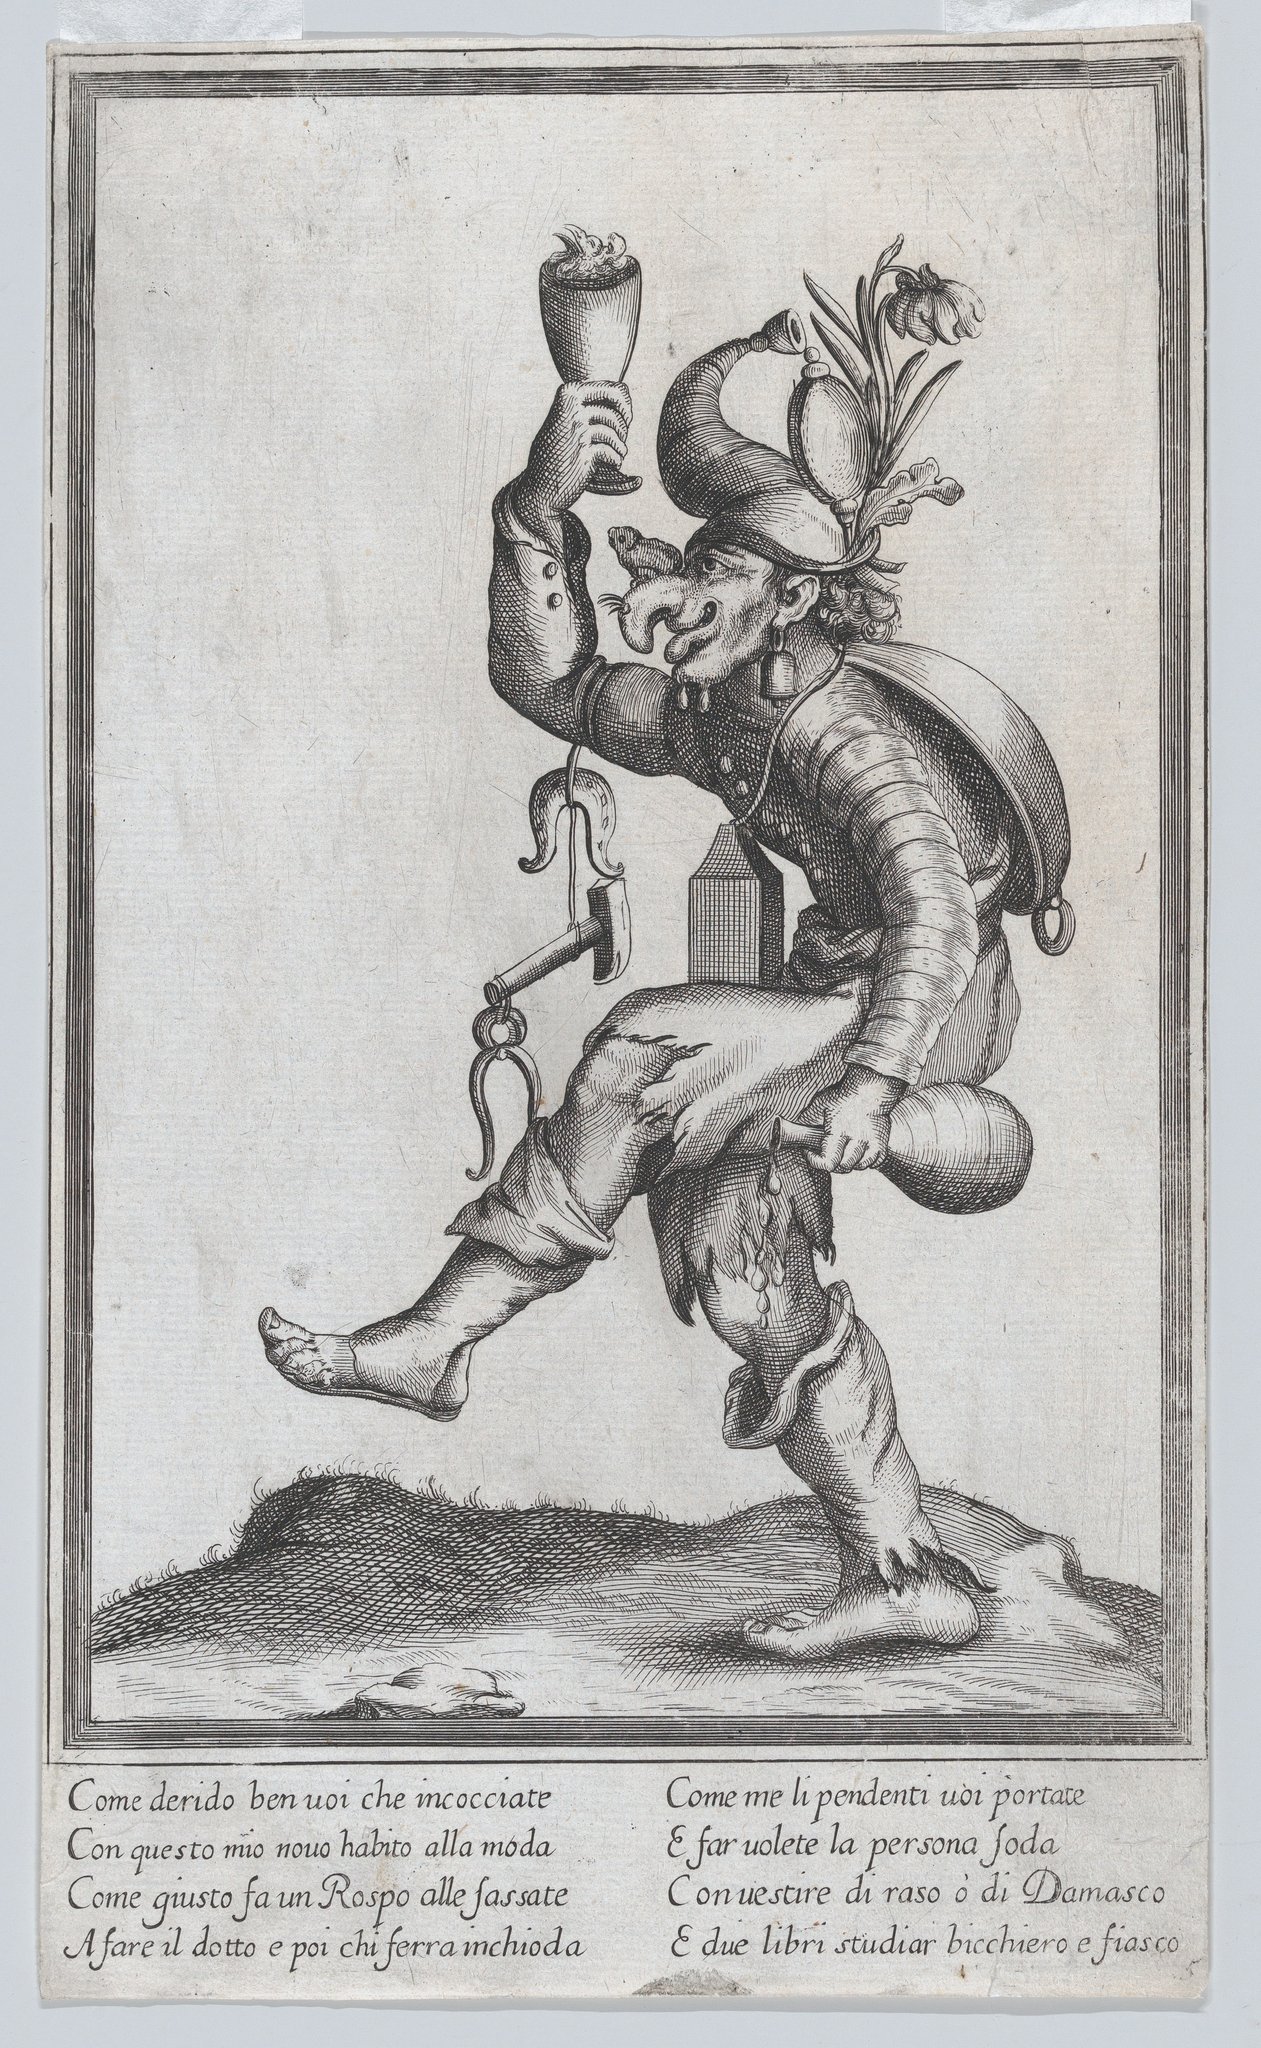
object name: print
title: A caricature figure (a carpenter?) with a toad on his nose, carrying various implements walking to the left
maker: anonymous, italian, 17th century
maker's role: artist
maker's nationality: italian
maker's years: 1600-1700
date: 1640-1660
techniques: engraving, etching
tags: satire,walking